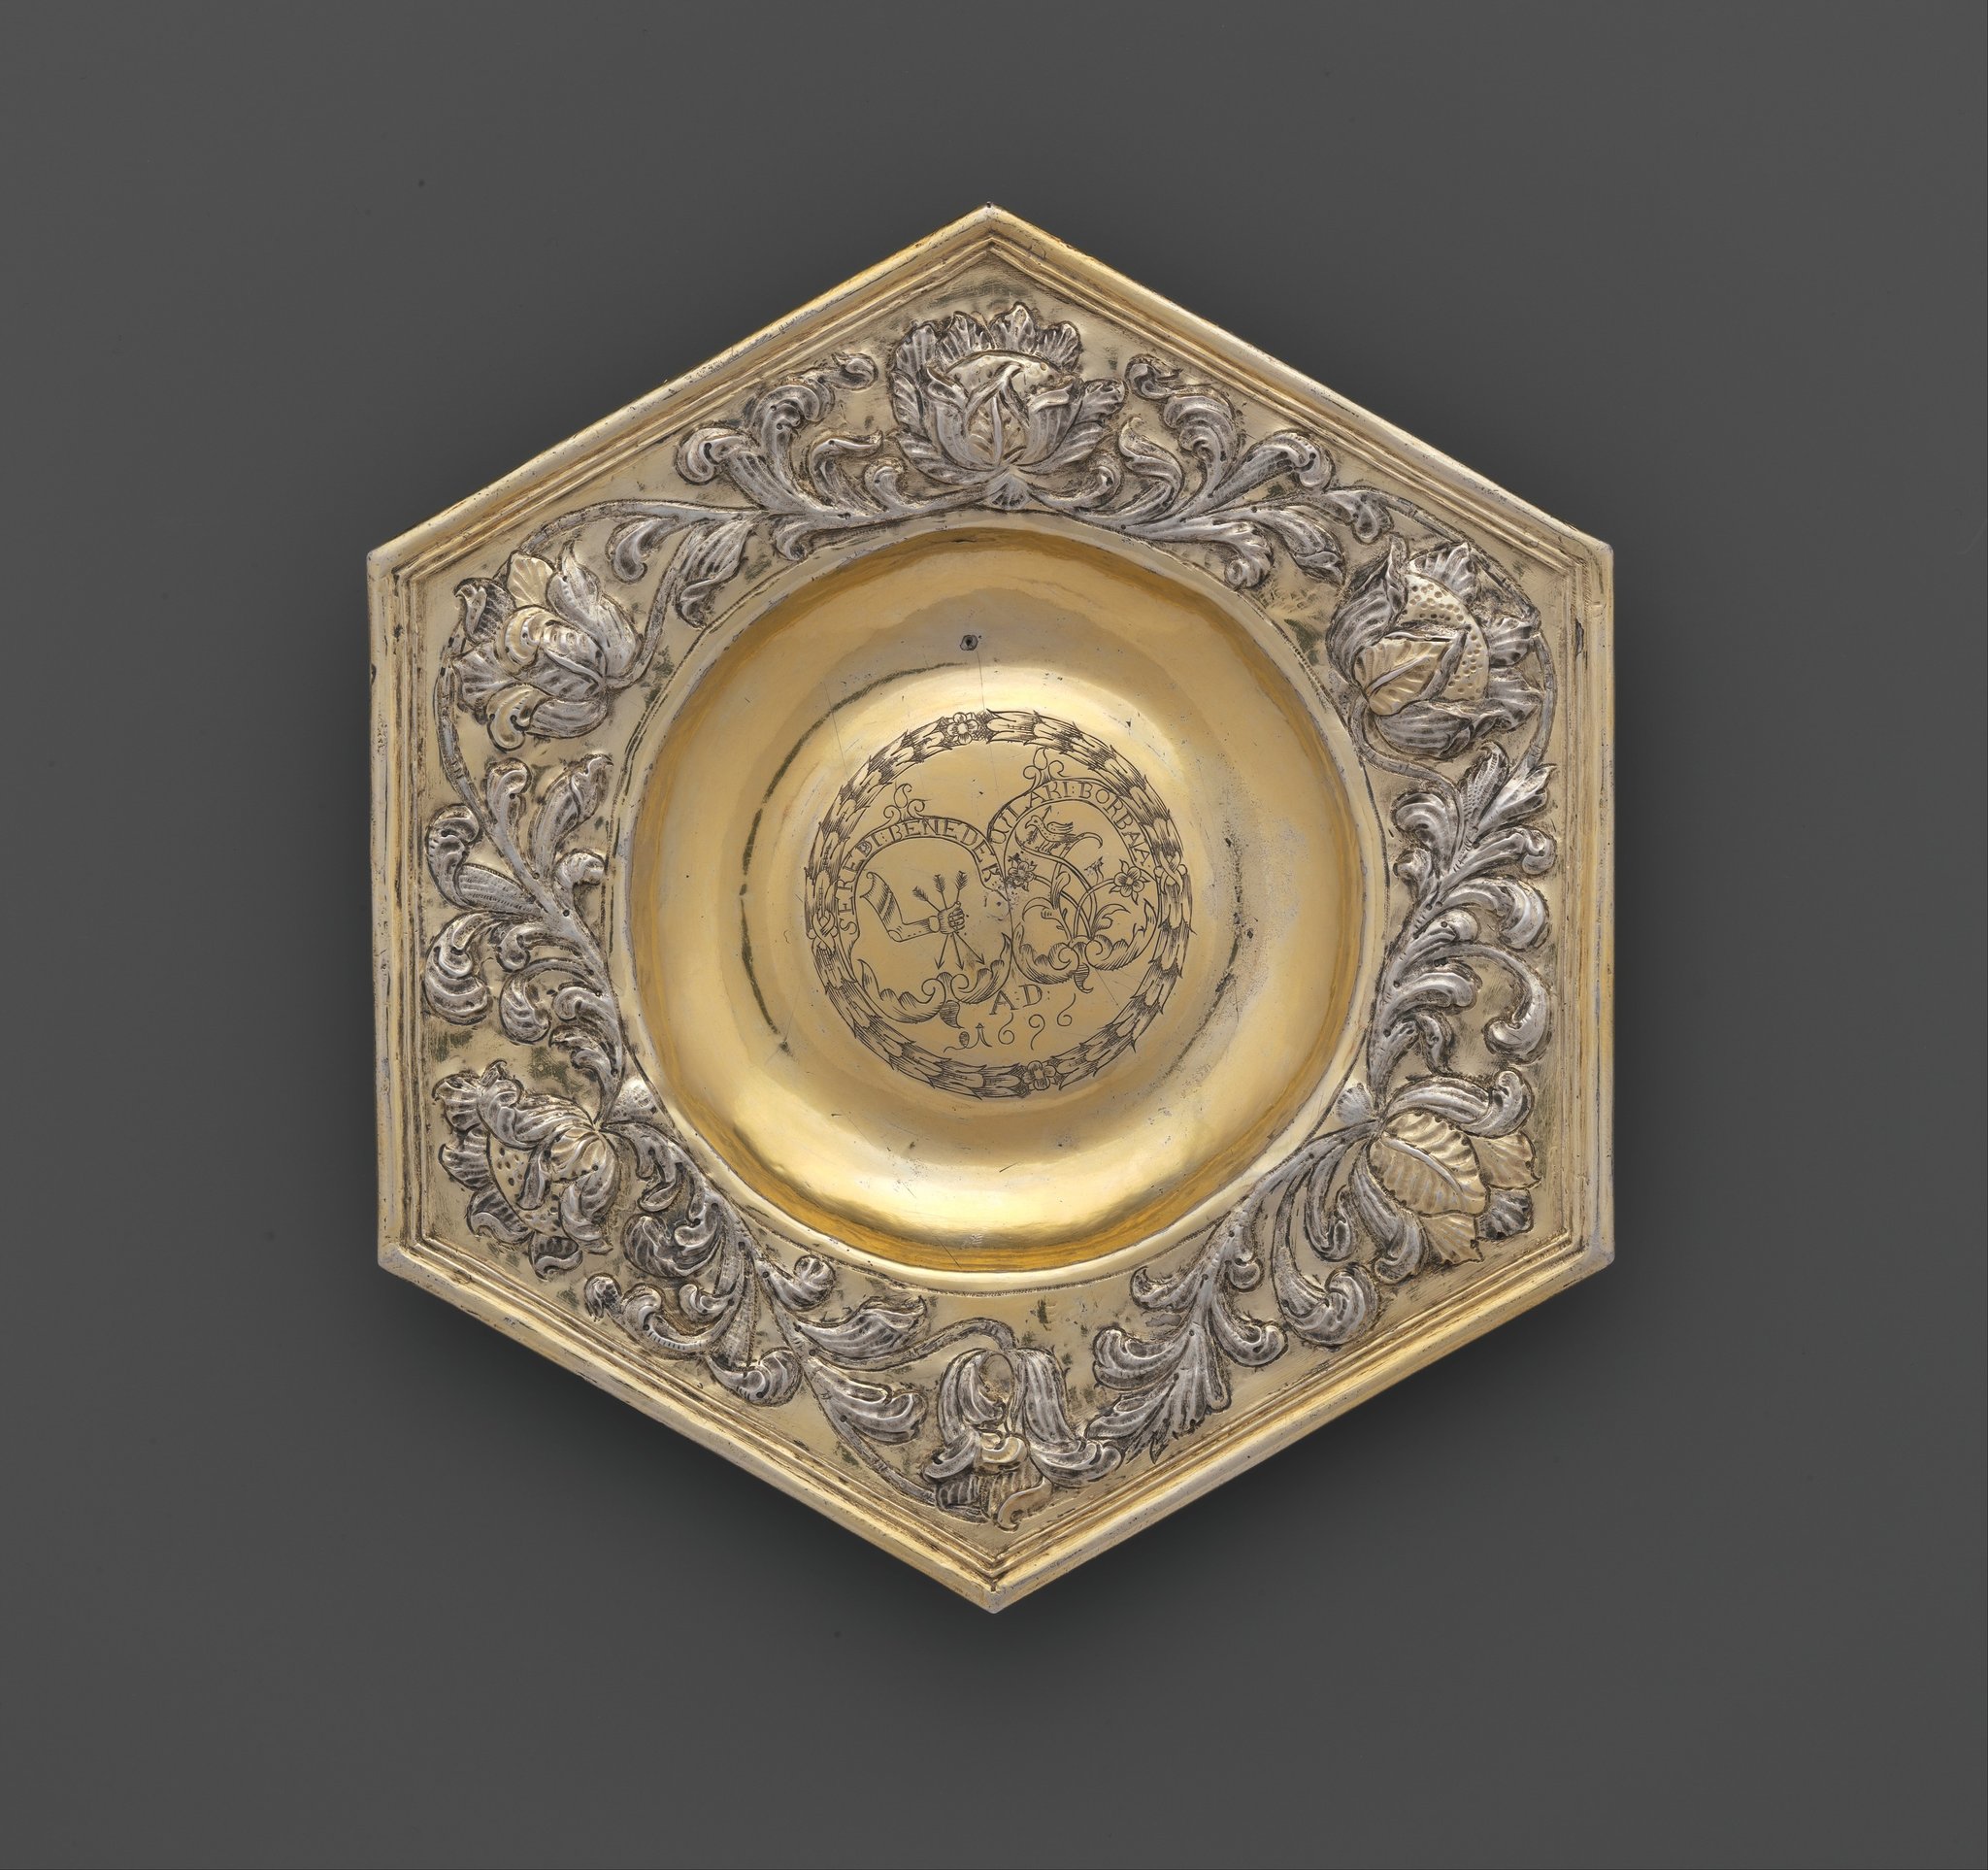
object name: dish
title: Hexagonal dish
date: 1696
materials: silver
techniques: gilding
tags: flowers,coat of arms